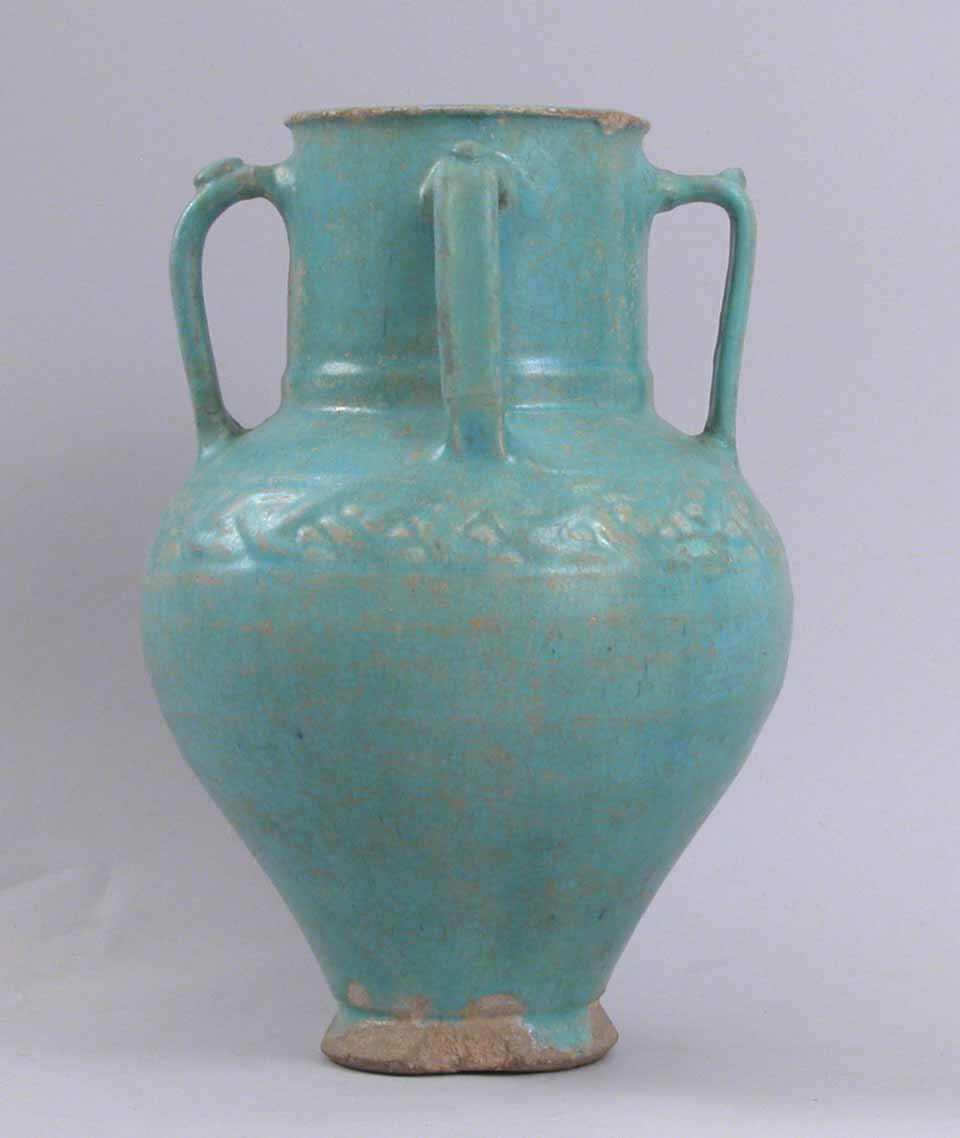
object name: vase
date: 1101-1200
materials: glaze, stonepaste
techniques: painting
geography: iran